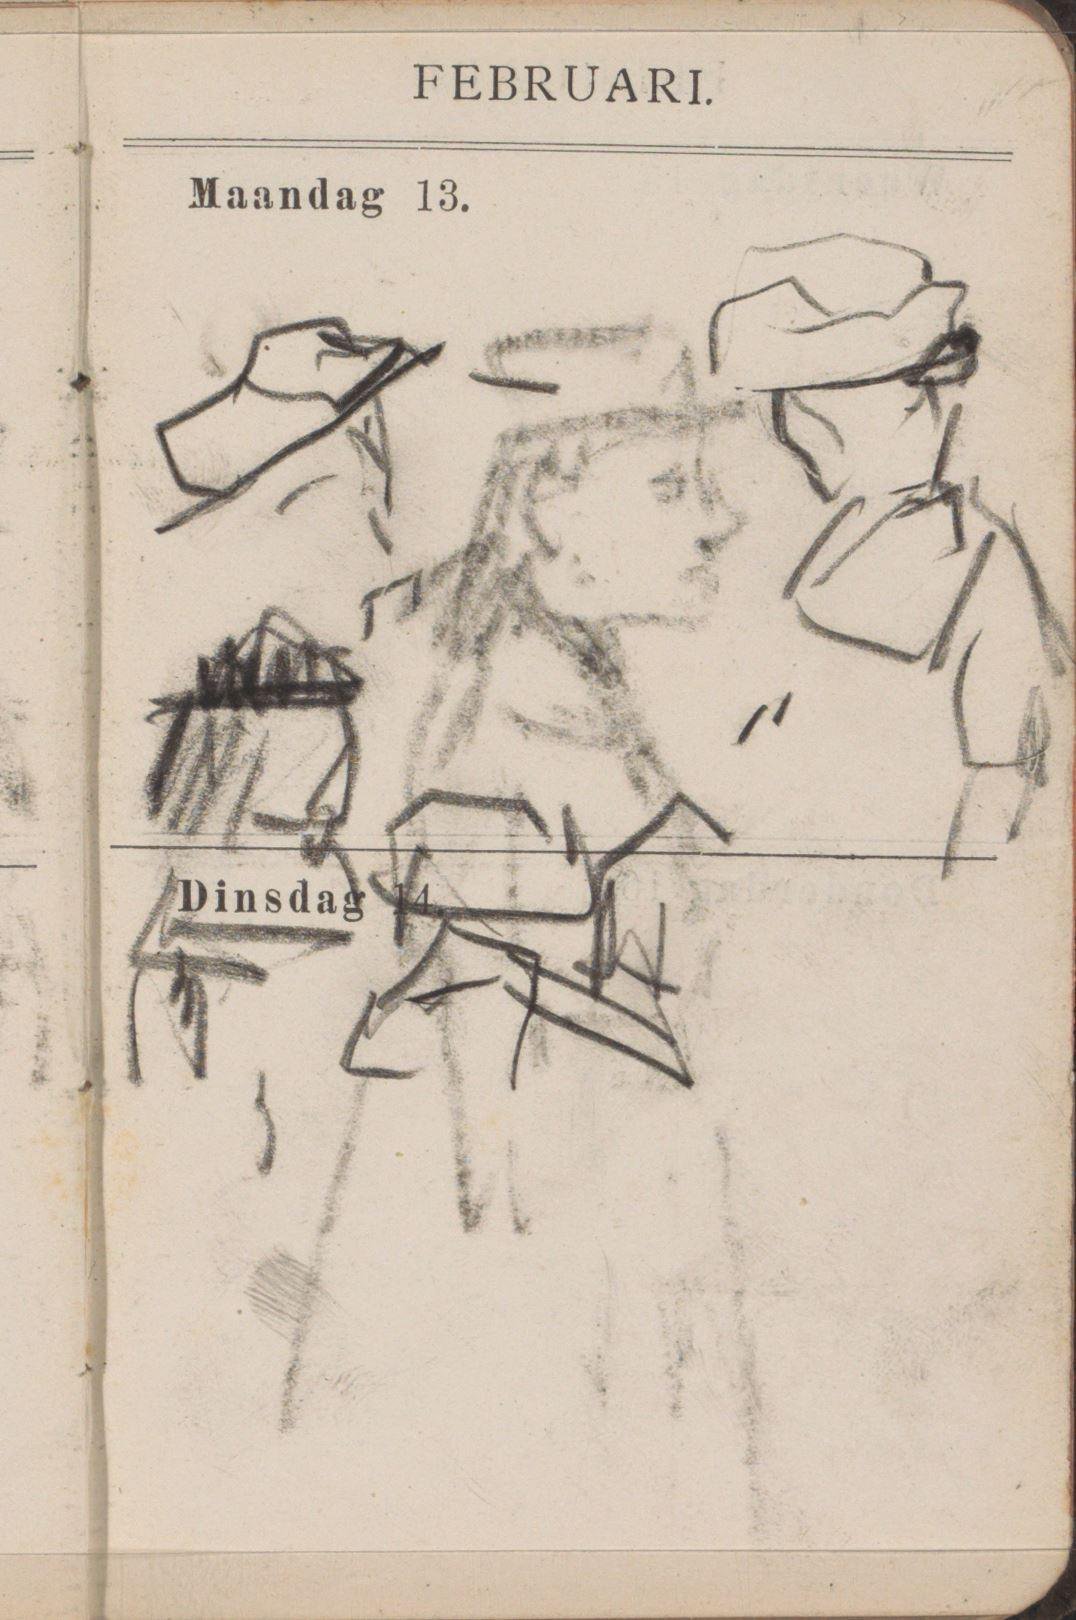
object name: sketchbook leaf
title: Figuurstudies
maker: george hendrik breitner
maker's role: draughtsman, painter, print maker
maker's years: 1857-1923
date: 1893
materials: chalk, paper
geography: amsterdam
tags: adult woman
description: Studieblad met vrouwen. Pagina 44 uit een als schetsboek gebruikte agenda met 108 bladen.